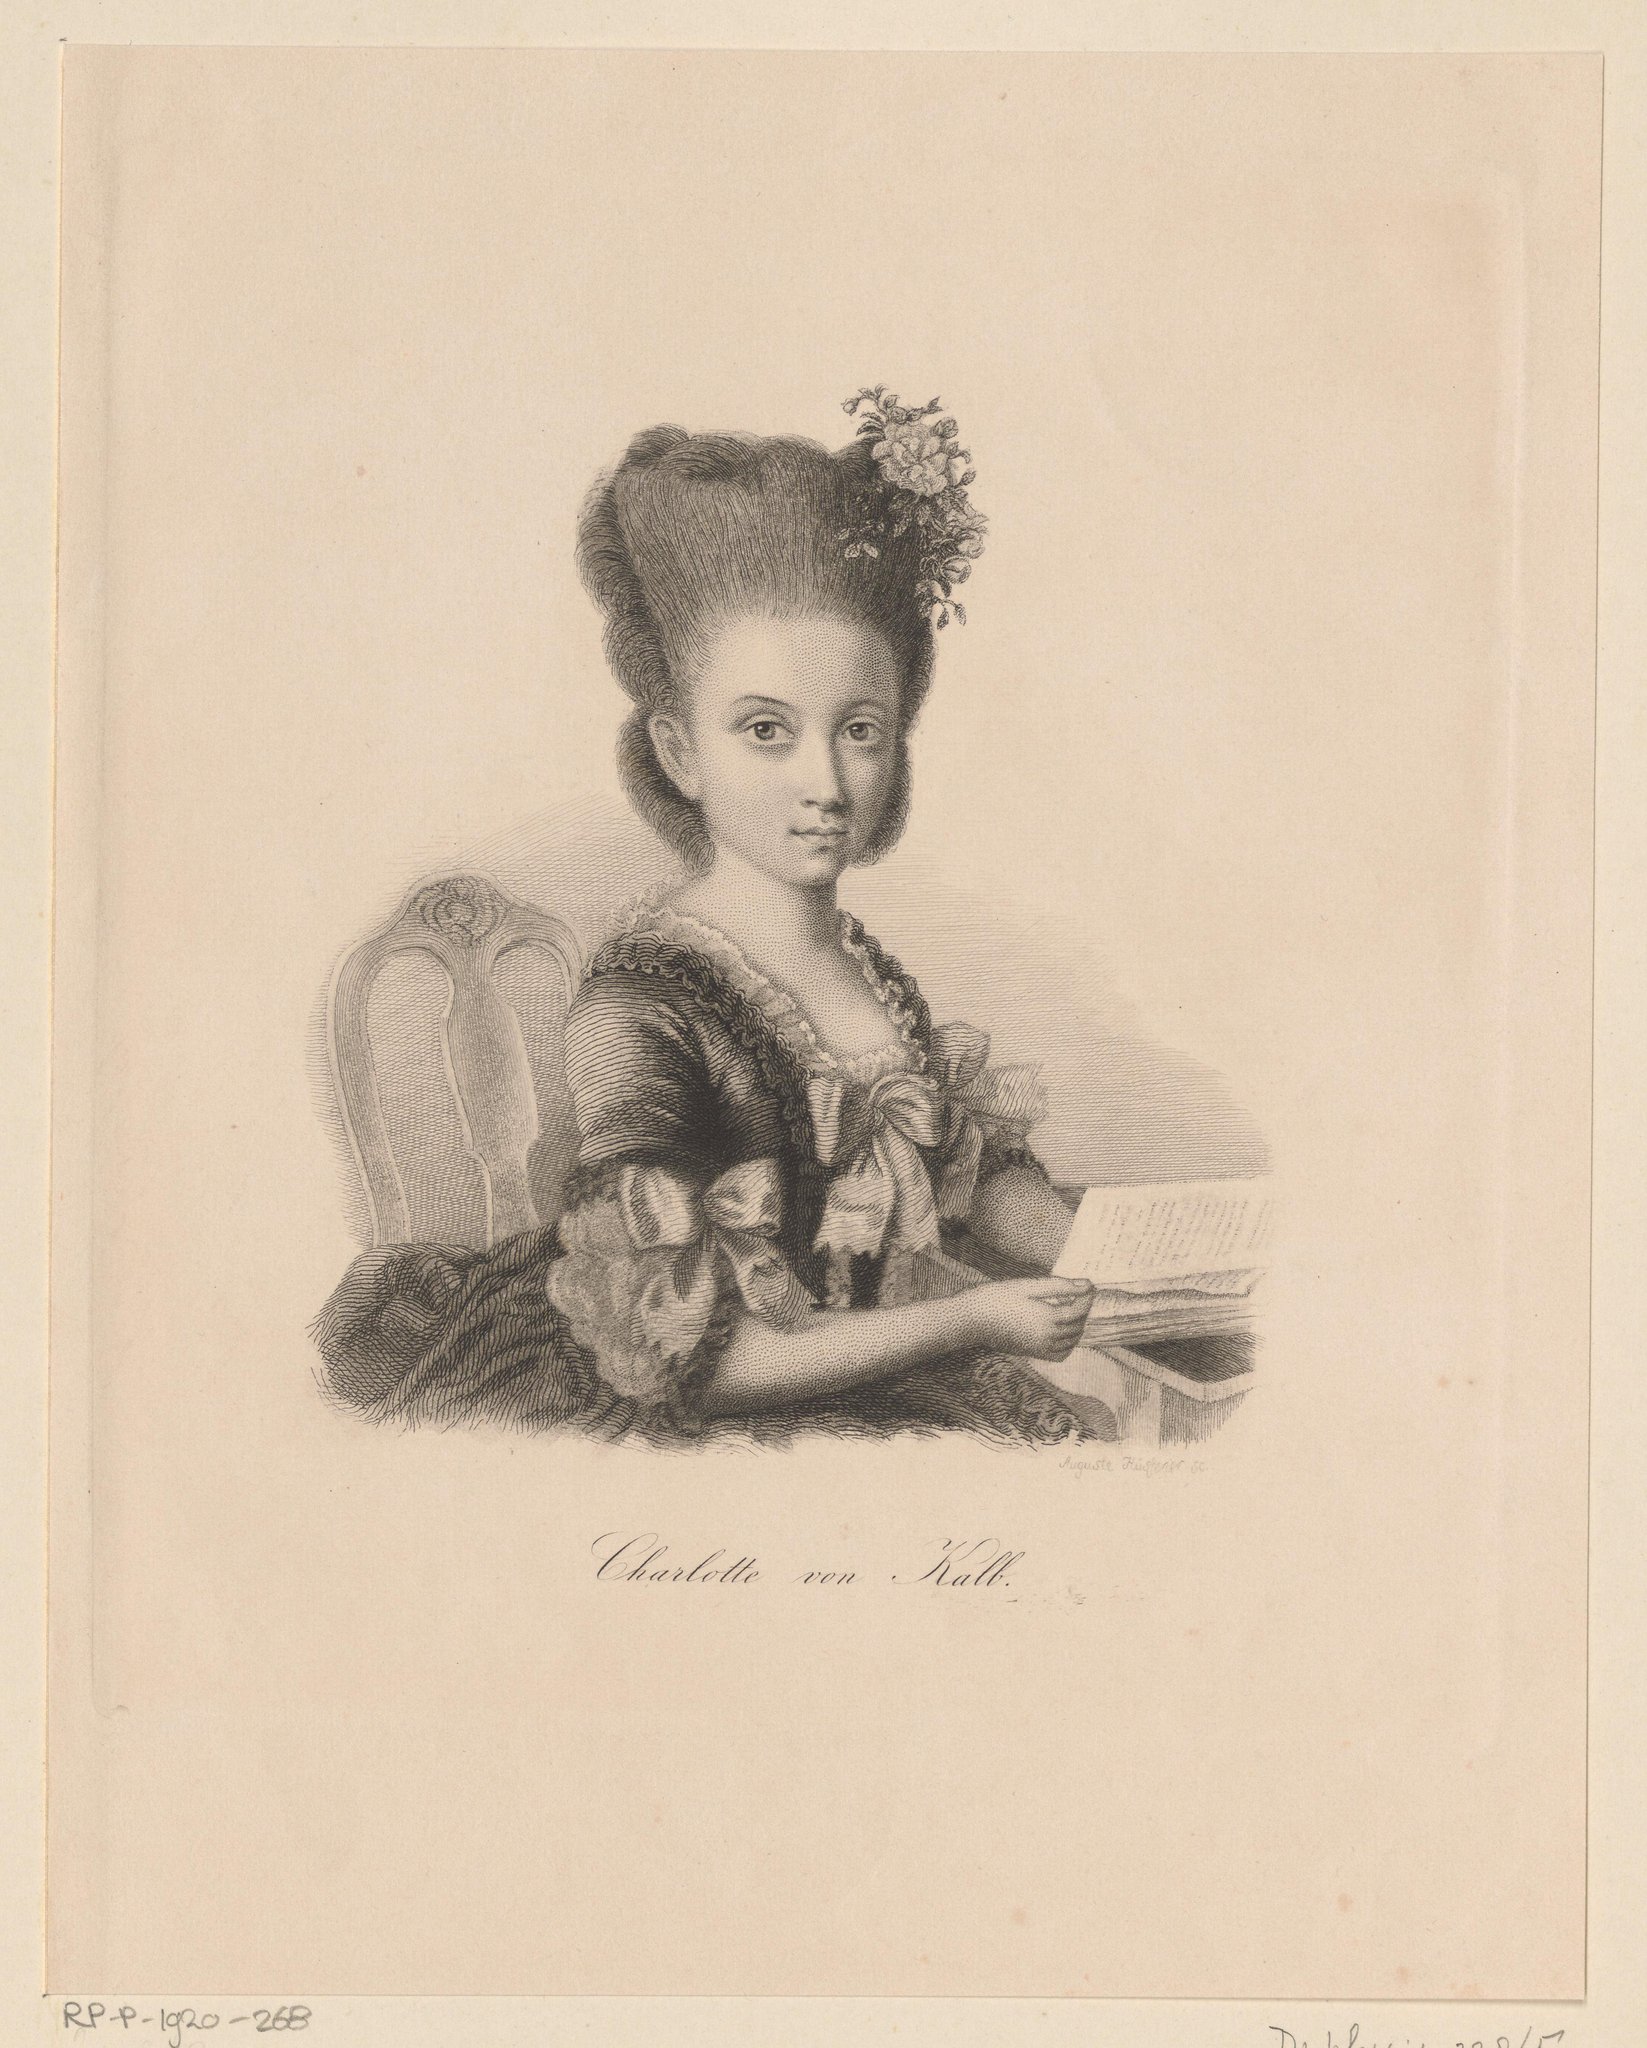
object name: print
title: Portret van Charlotte von Kalb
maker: auguste hüssener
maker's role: print maker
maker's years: 1789-1877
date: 1799-1877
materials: paper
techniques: engraving, etching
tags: reading, historical persons - bb - woman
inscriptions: collector's mark: Lugt 2228